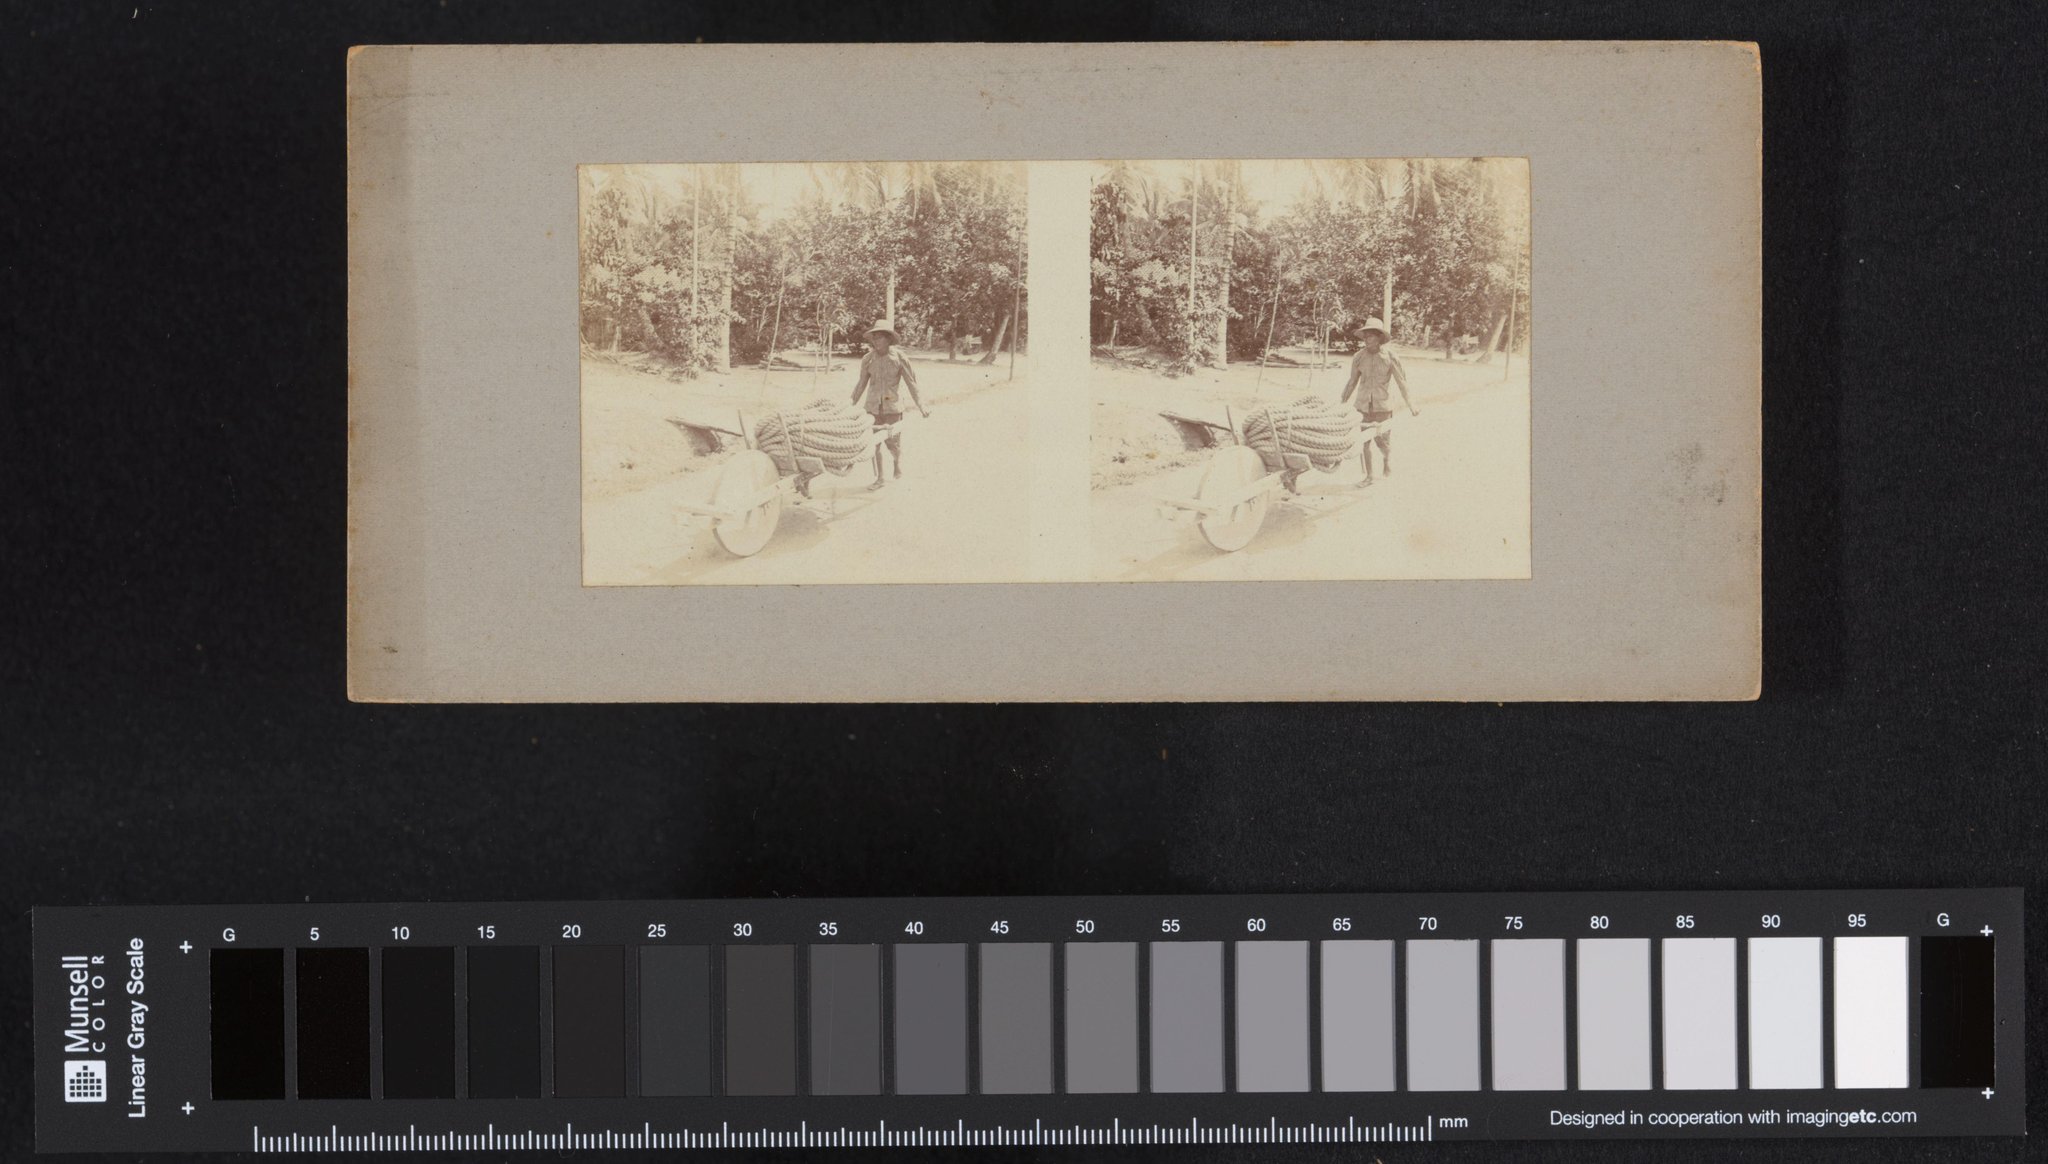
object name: stereograph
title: Kruier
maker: robert julius boers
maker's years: 1867-1932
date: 1900-1922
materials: cardboard, photographic support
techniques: gelatin silver print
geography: bangka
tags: robert julius boers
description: Indische kruier met een kruiwagen met touw, op Banka. Onderdeel van een groep stereofoto's van Robert Julius Boers, chef van het staatsbedrijf de Banka-tinwinning op Banka, uit de periode ca. 1900-1922.